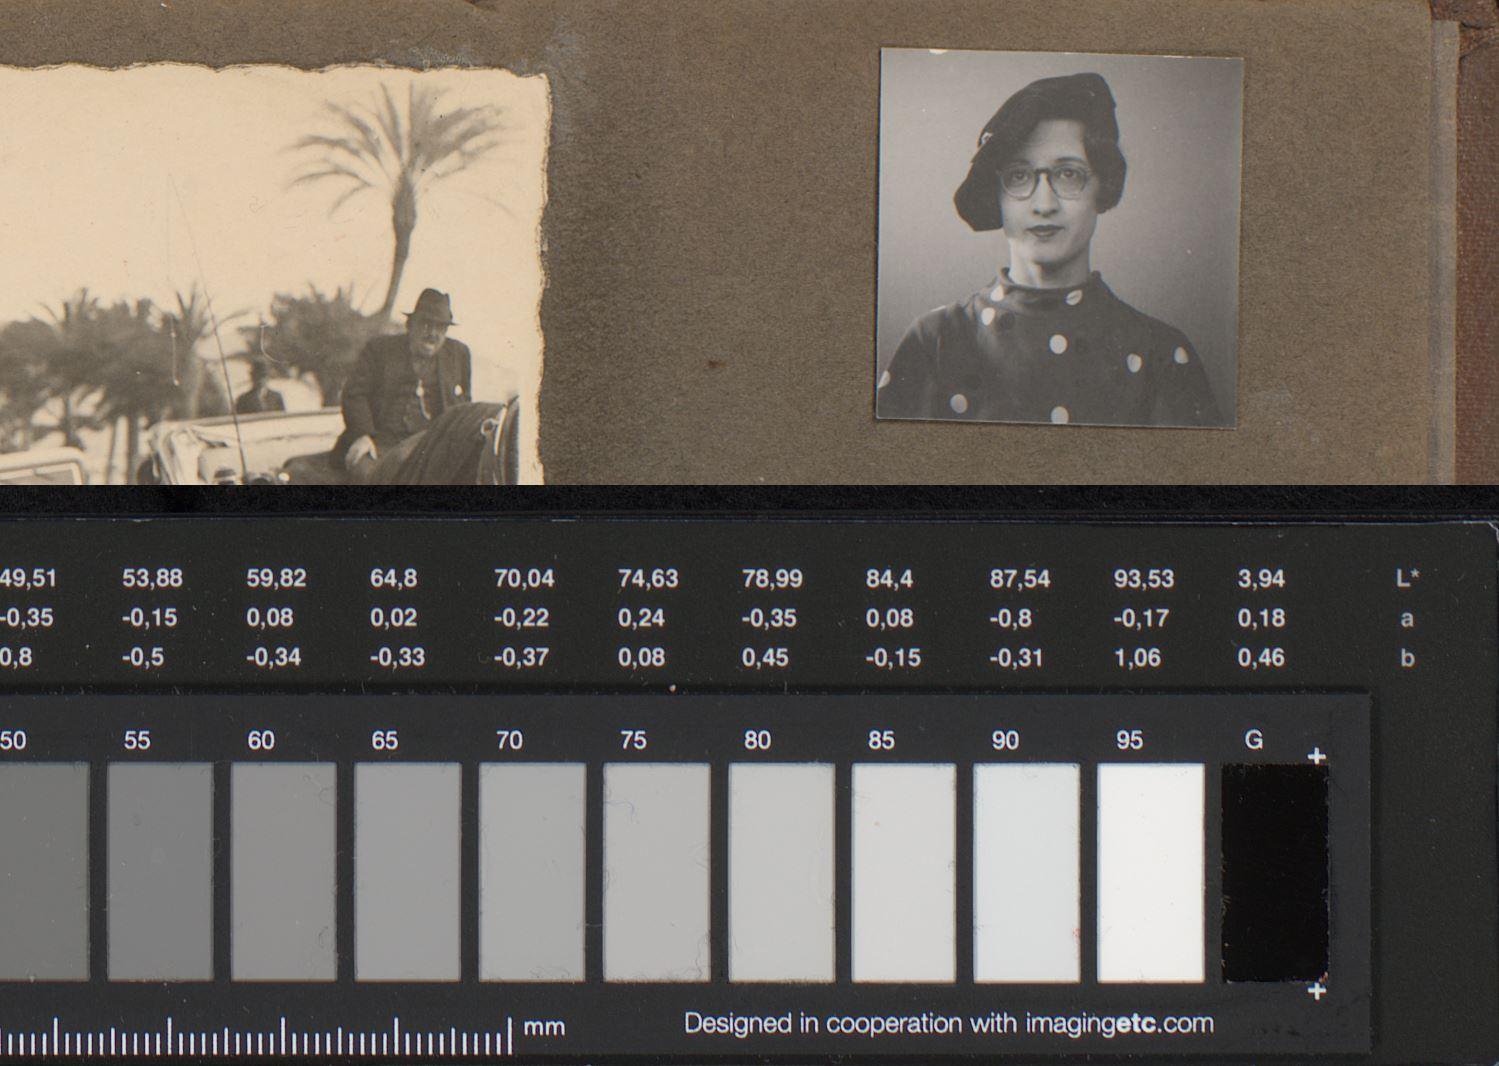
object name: photograph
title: Portret van Dootje met baret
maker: Anonymous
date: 1934-1935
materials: paper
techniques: gelatin silver print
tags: amsterdam, historical persons - bb - woman, head-gear: beret